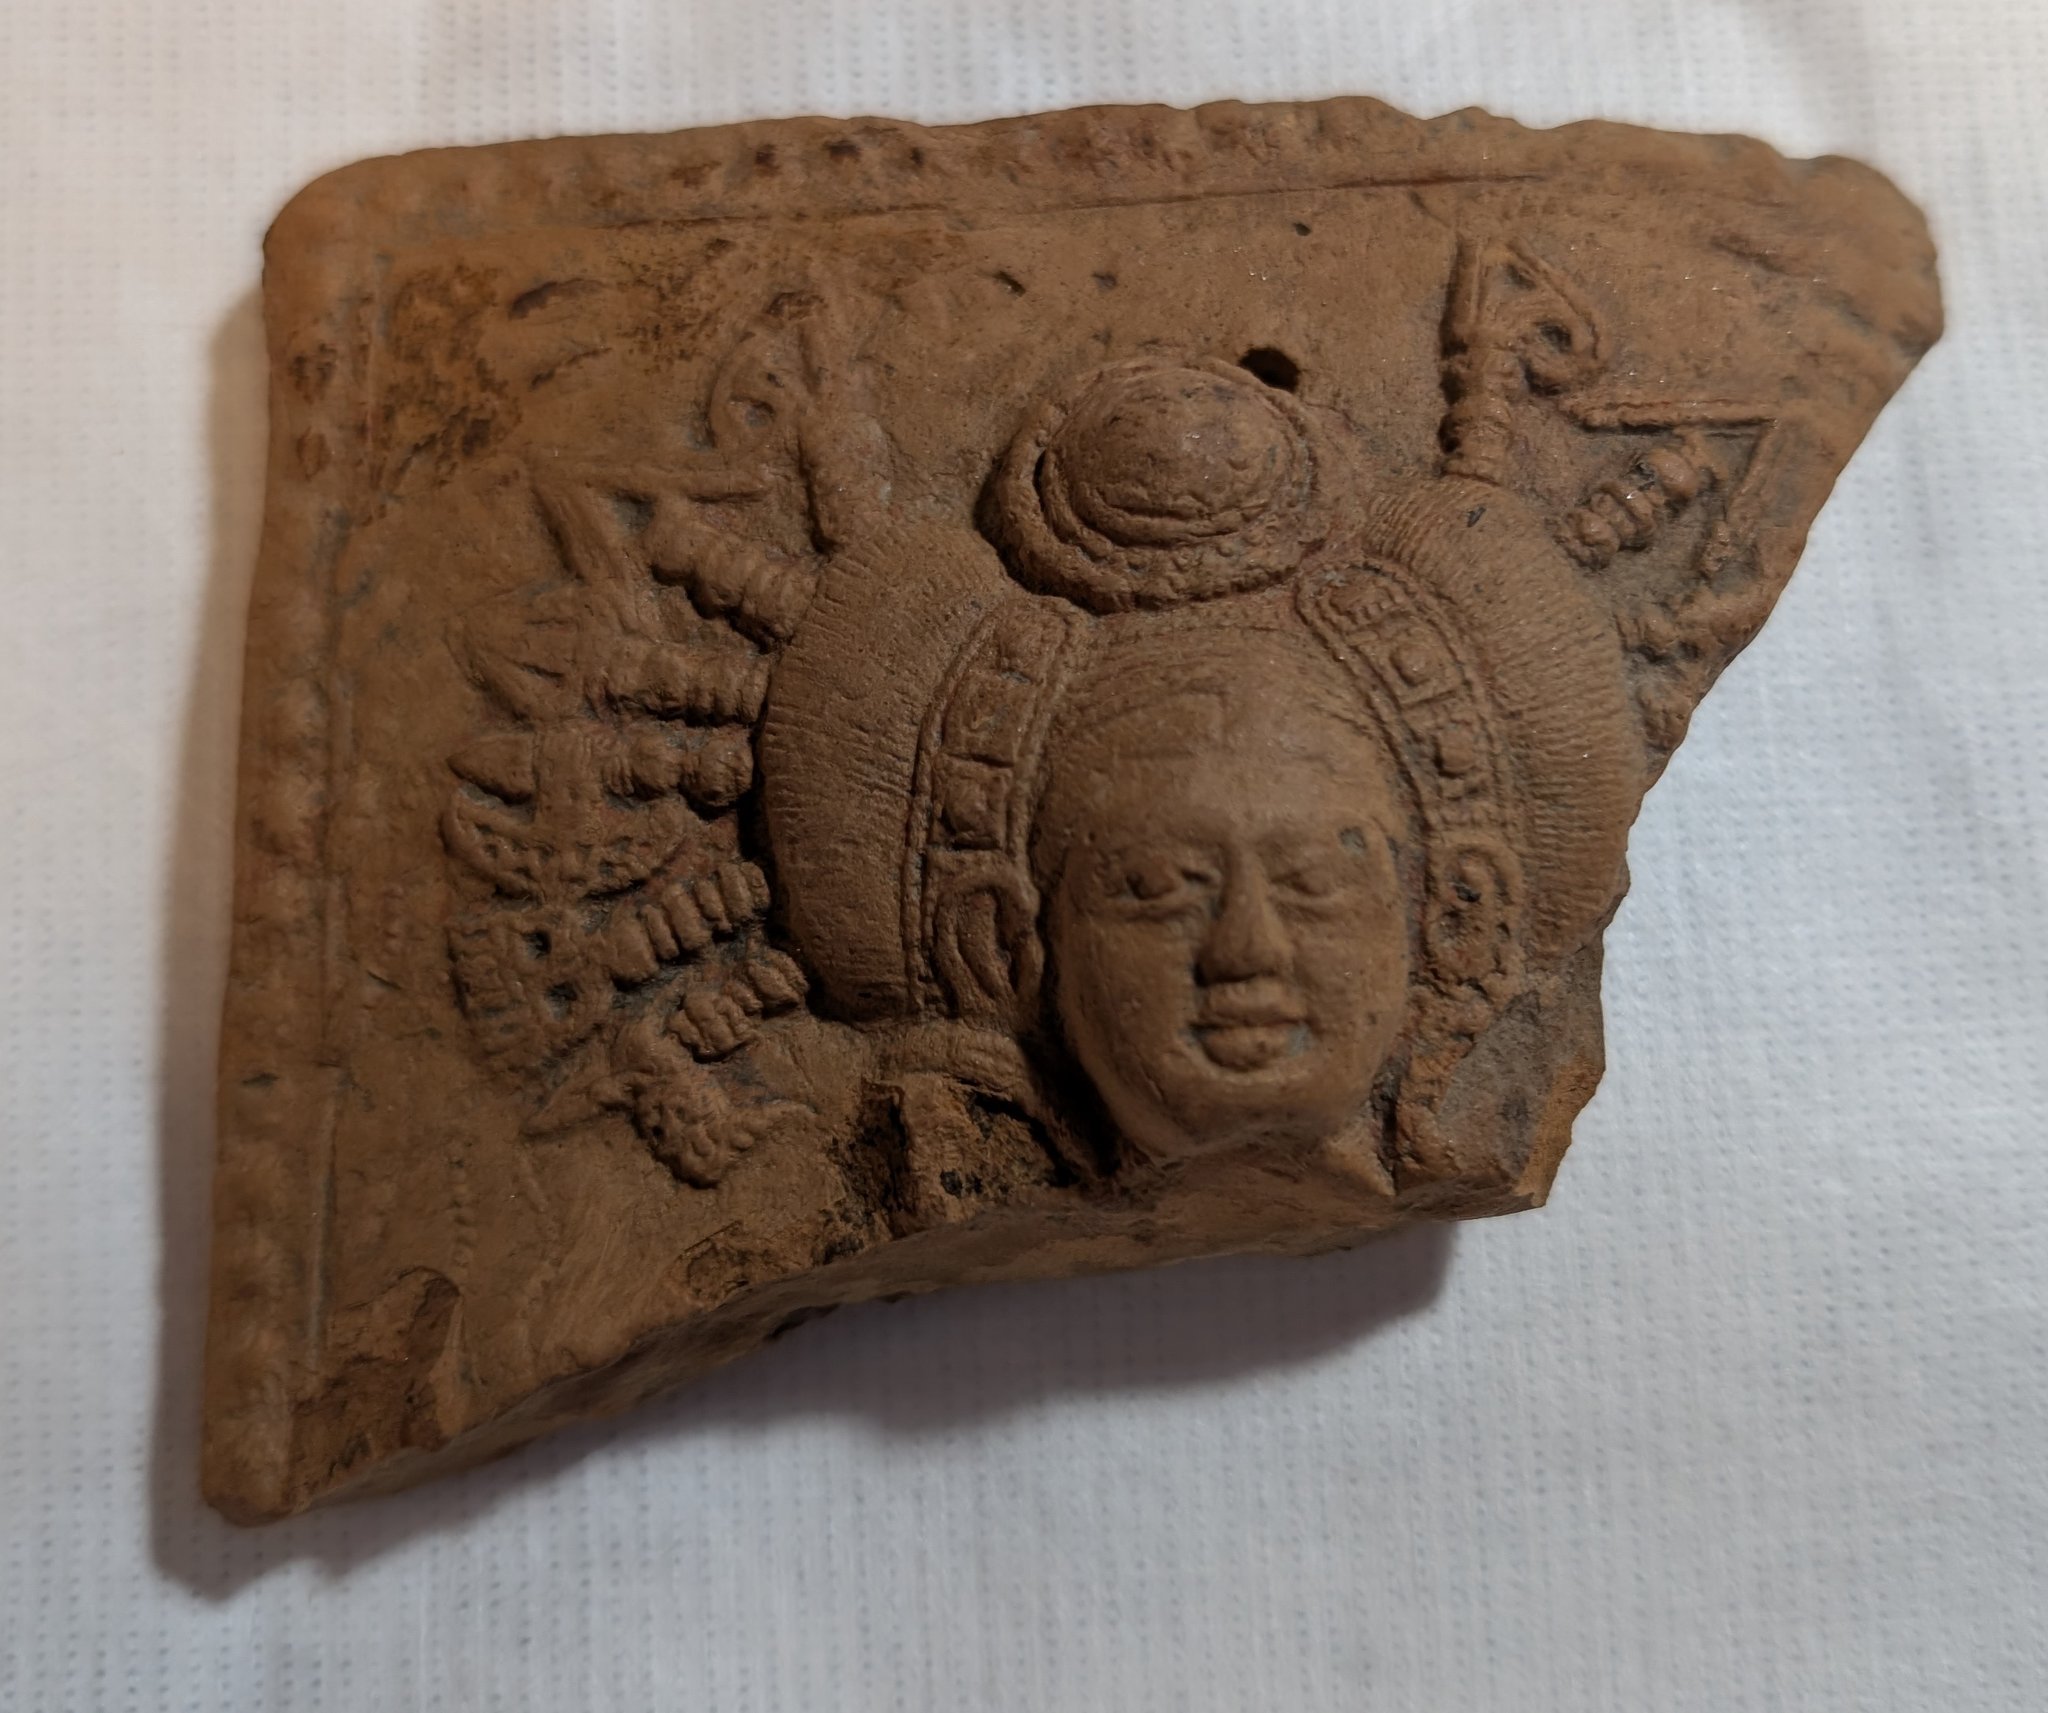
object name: plaque fragment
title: Fragment of a Plaque with a Female Head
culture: indian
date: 100-1 BCE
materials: terracotta